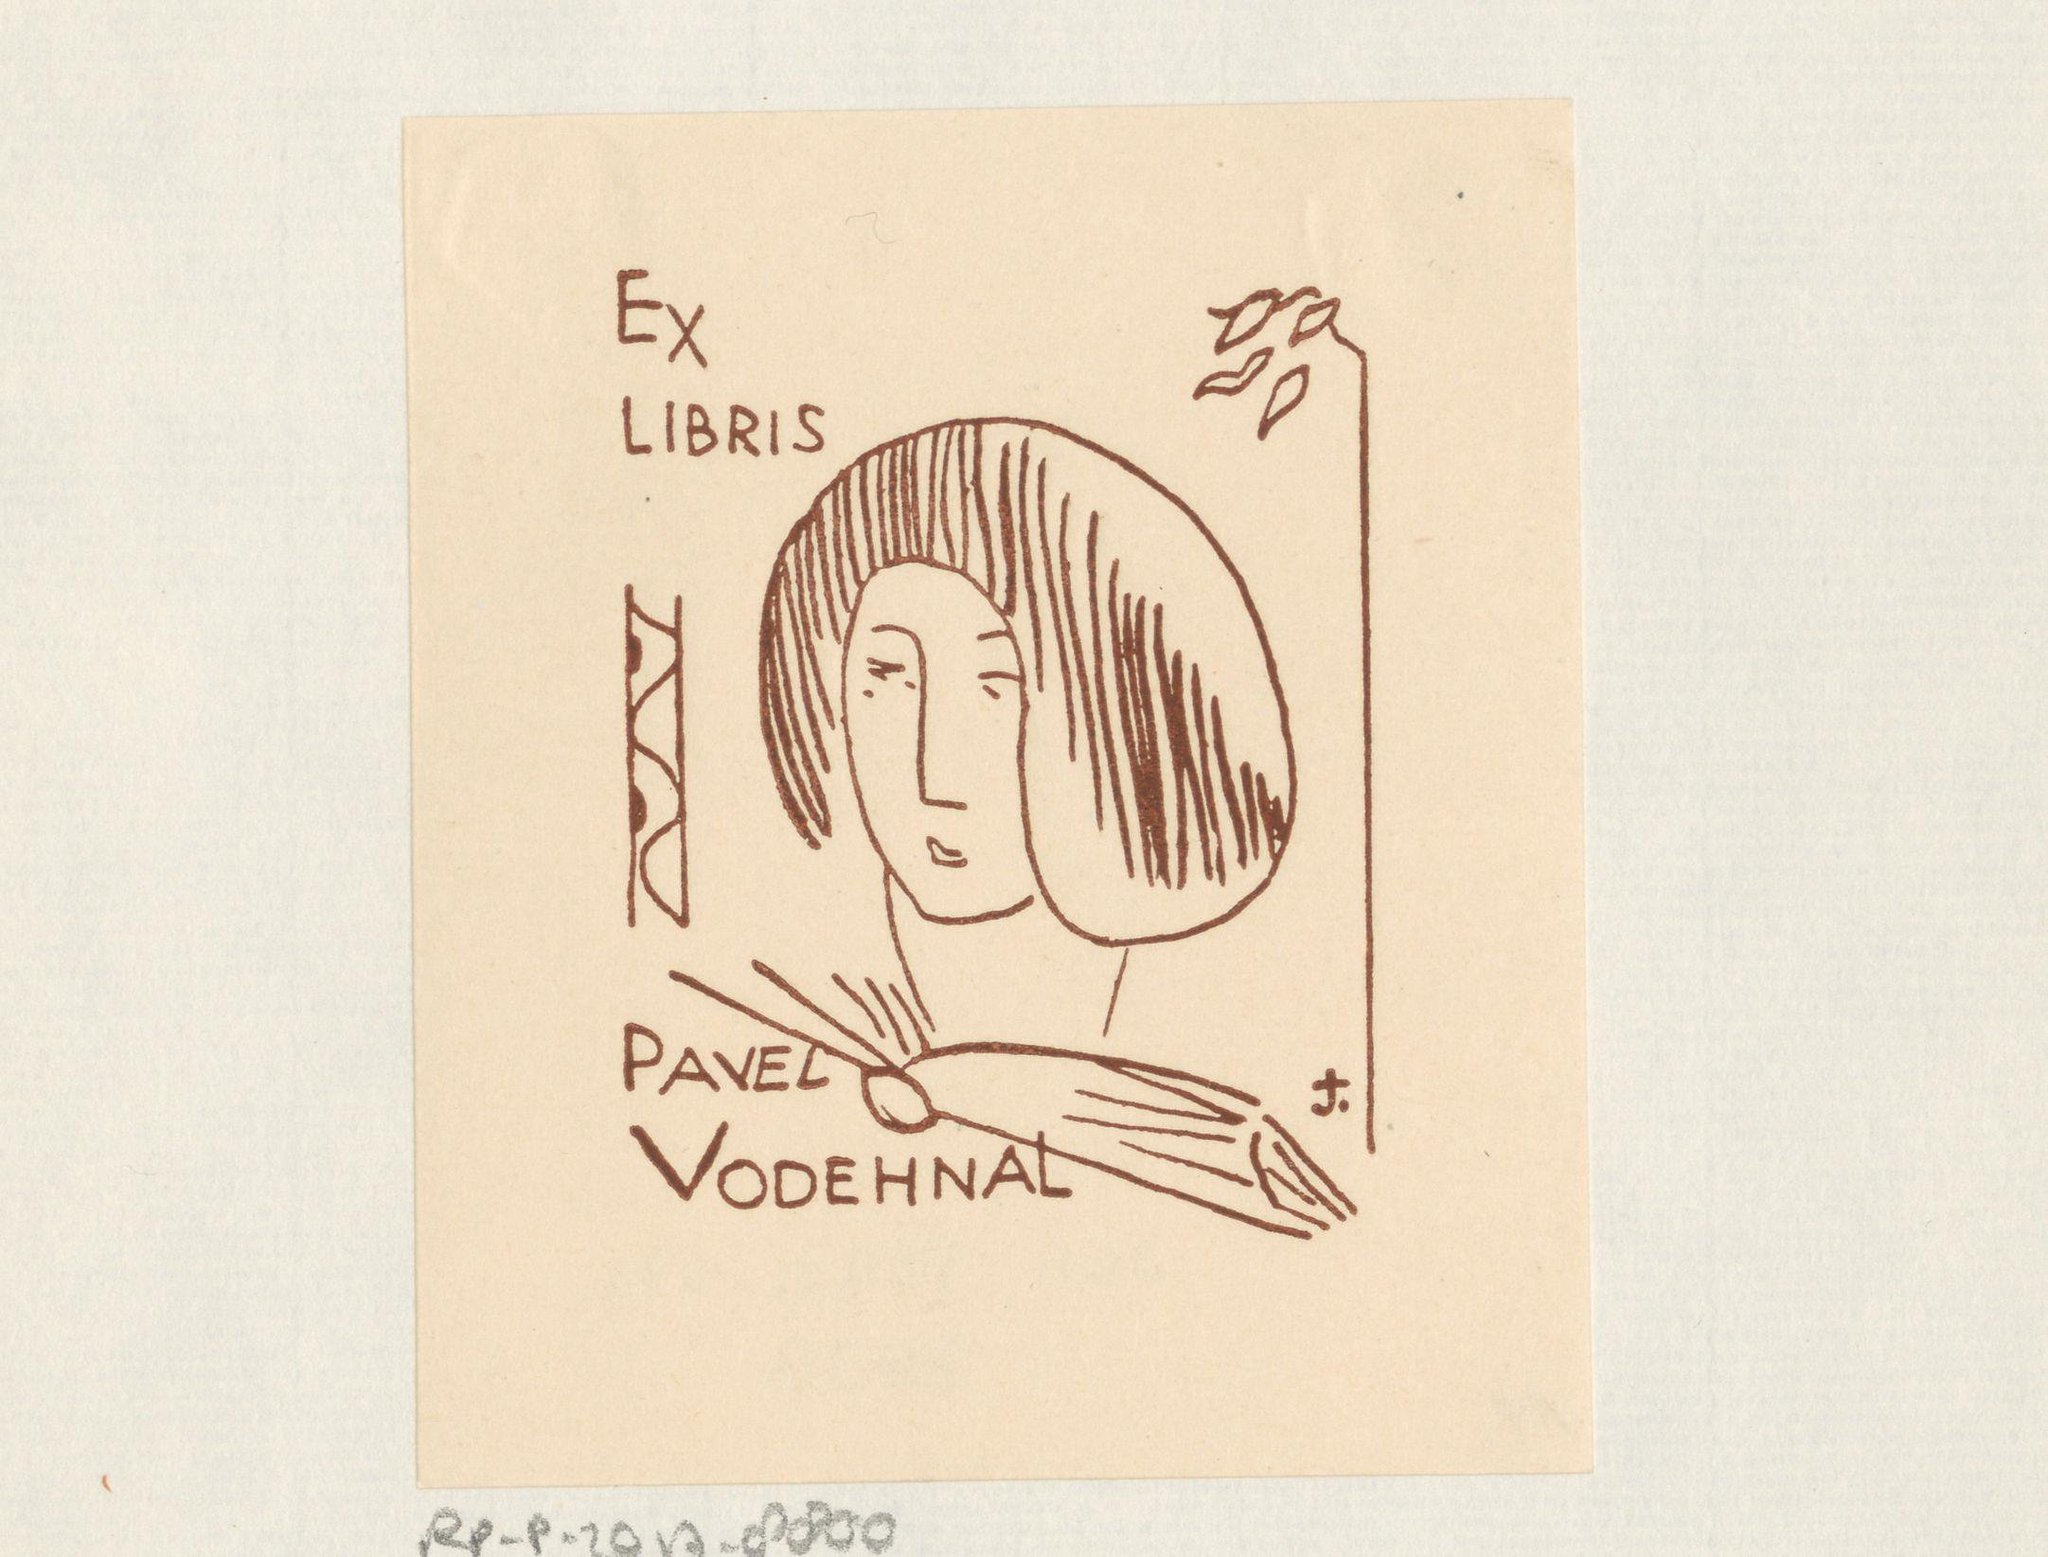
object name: bookplate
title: Ex libris van Pavel Vodehnal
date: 1930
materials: paper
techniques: printing block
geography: czech republic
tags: head (human), book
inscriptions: workshop stamp: ‘Jan Trampota/ 1930’